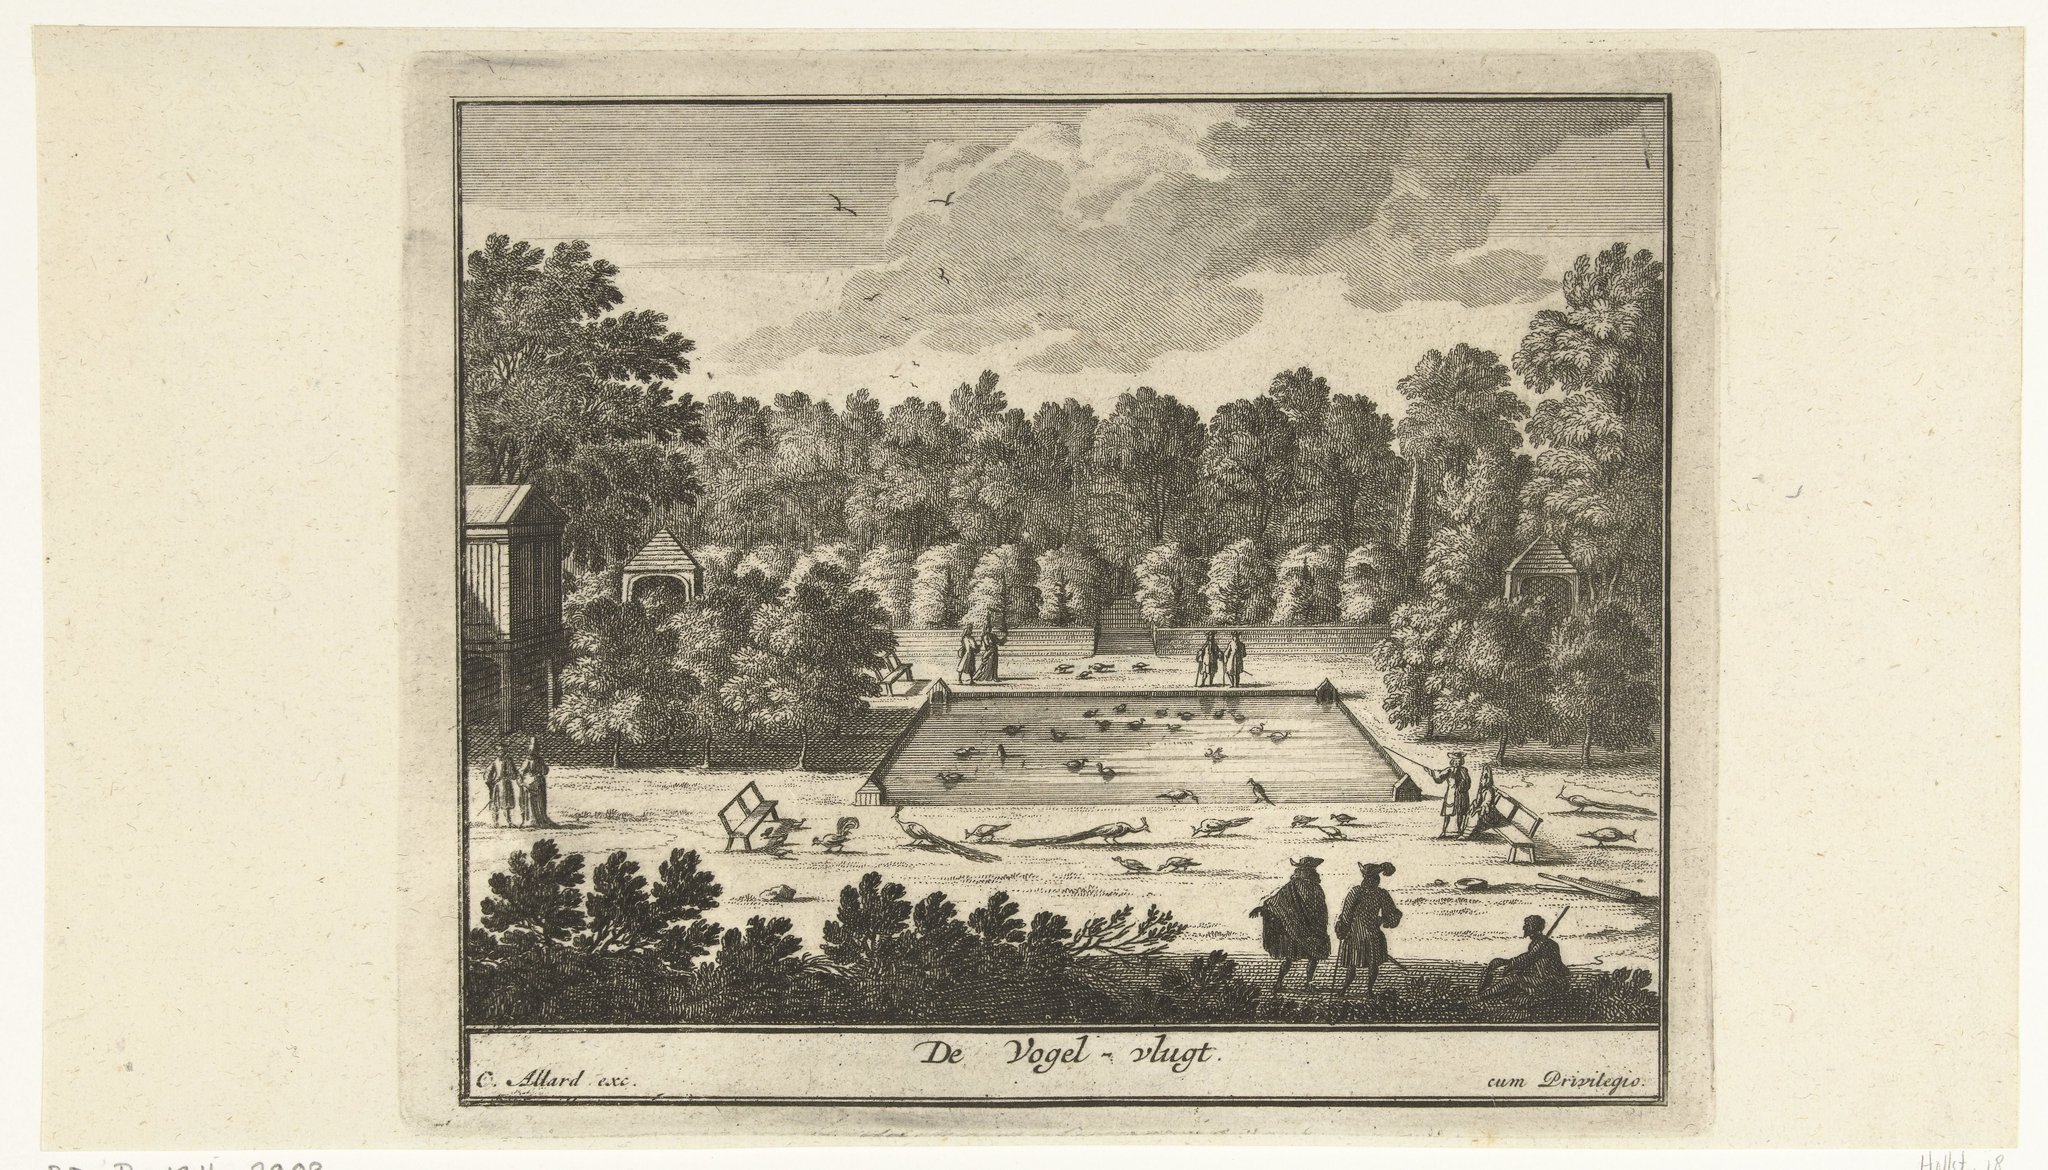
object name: print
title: Hollands Lustpark besluitende zyn Britannische majesteits hof-gebouw tot Honslaardyk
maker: carel allard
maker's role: print maker, publisher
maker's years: 1648-1709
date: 1689-1702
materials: paper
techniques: etching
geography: amsterdam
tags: domestic birds kept outside the house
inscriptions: collector's mark: Lugt 2228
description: Park met vogelvijver en allerlei soorten vogels. Groepjes wandelaars staand of zittend op een bank. Prent uit een serie van zeventien prenten van Paleis Honselaarsdijk.